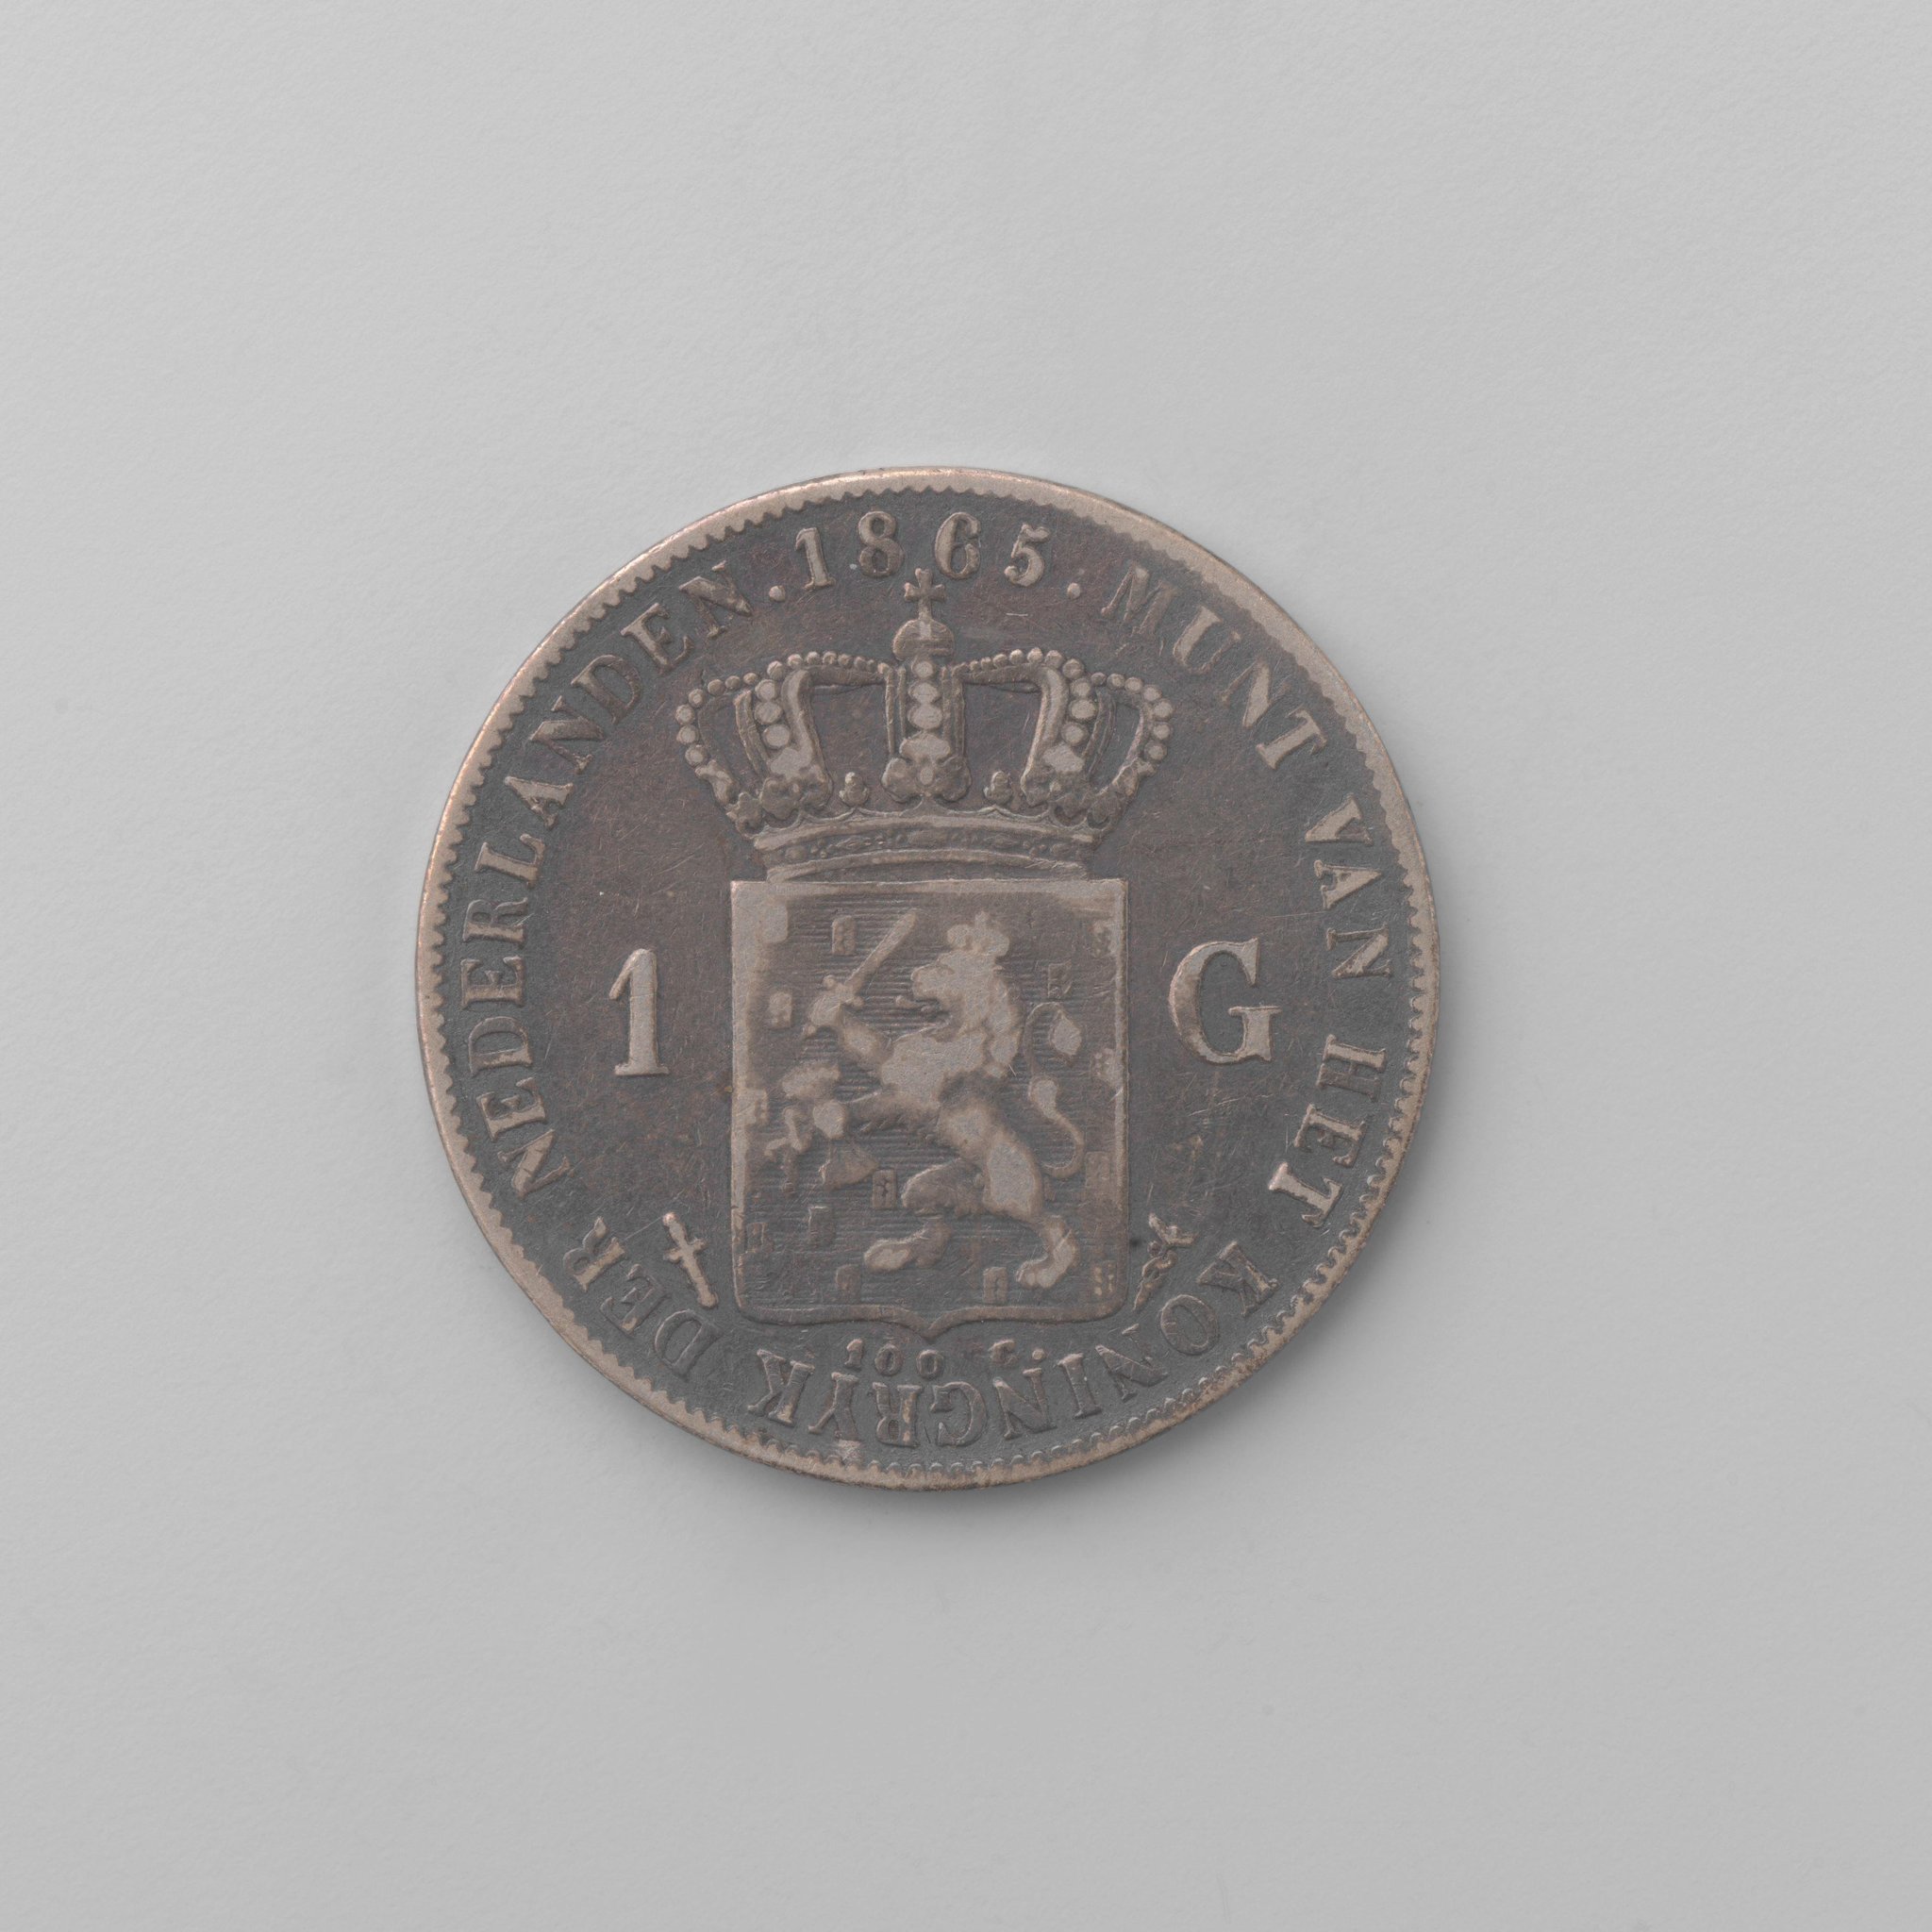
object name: coin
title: Nederland, gulden, 1865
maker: willem iii (koning der nederlanden)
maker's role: koning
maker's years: 1817-1890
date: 1865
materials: silver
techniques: striking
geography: utrecht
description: Zilveren munt. Voorzijde: borstbeeld naar rechts. Keerzijde: tussen waarde-aanduiding 1 G gekroond rijkswapenschild. Jaartal boven kroon. Randschrift.